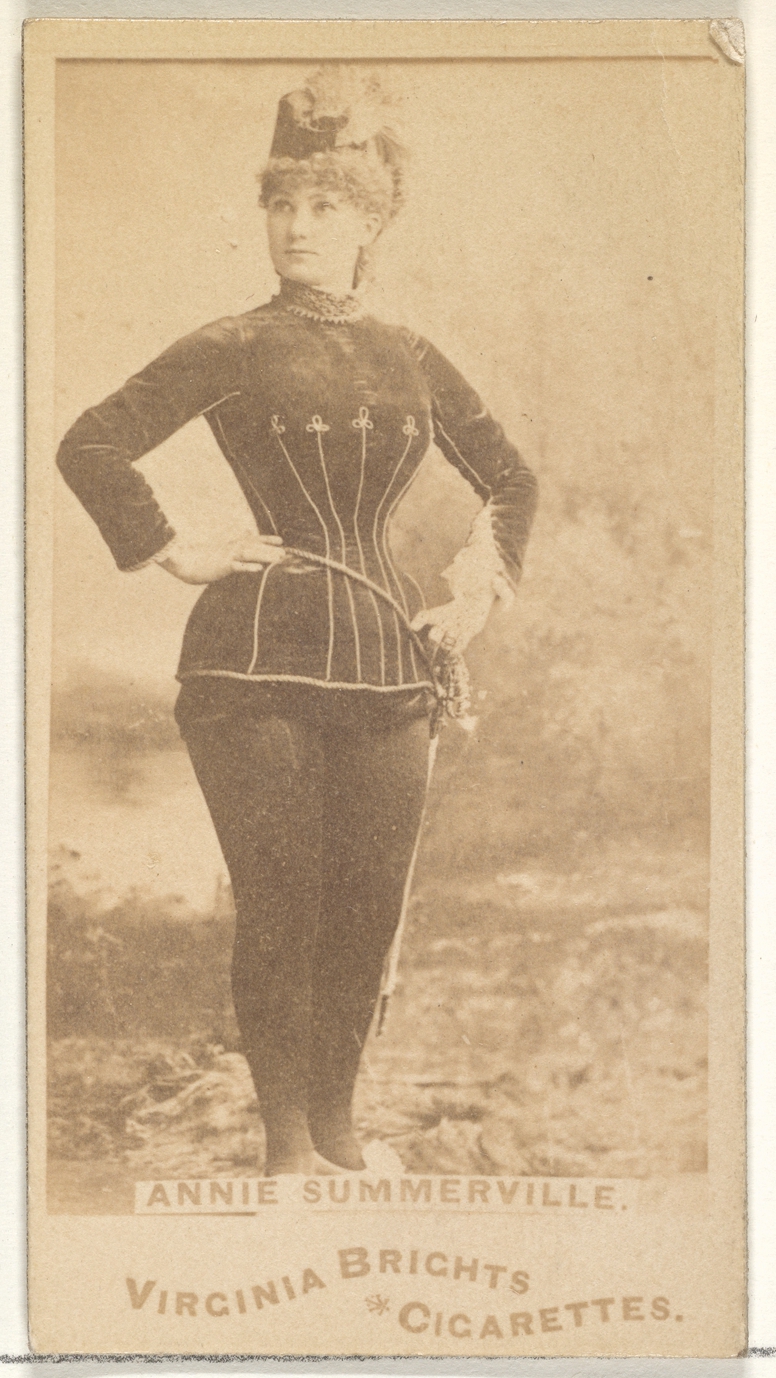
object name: photograph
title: Annie Summerville, from the Actors and Actresses series (N45, Type 1) for Virginia Brights Cigarettes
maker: allen & ginter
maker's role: publisher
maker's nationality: american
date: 1888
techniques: albumen silver print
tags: portraits,women,actresses